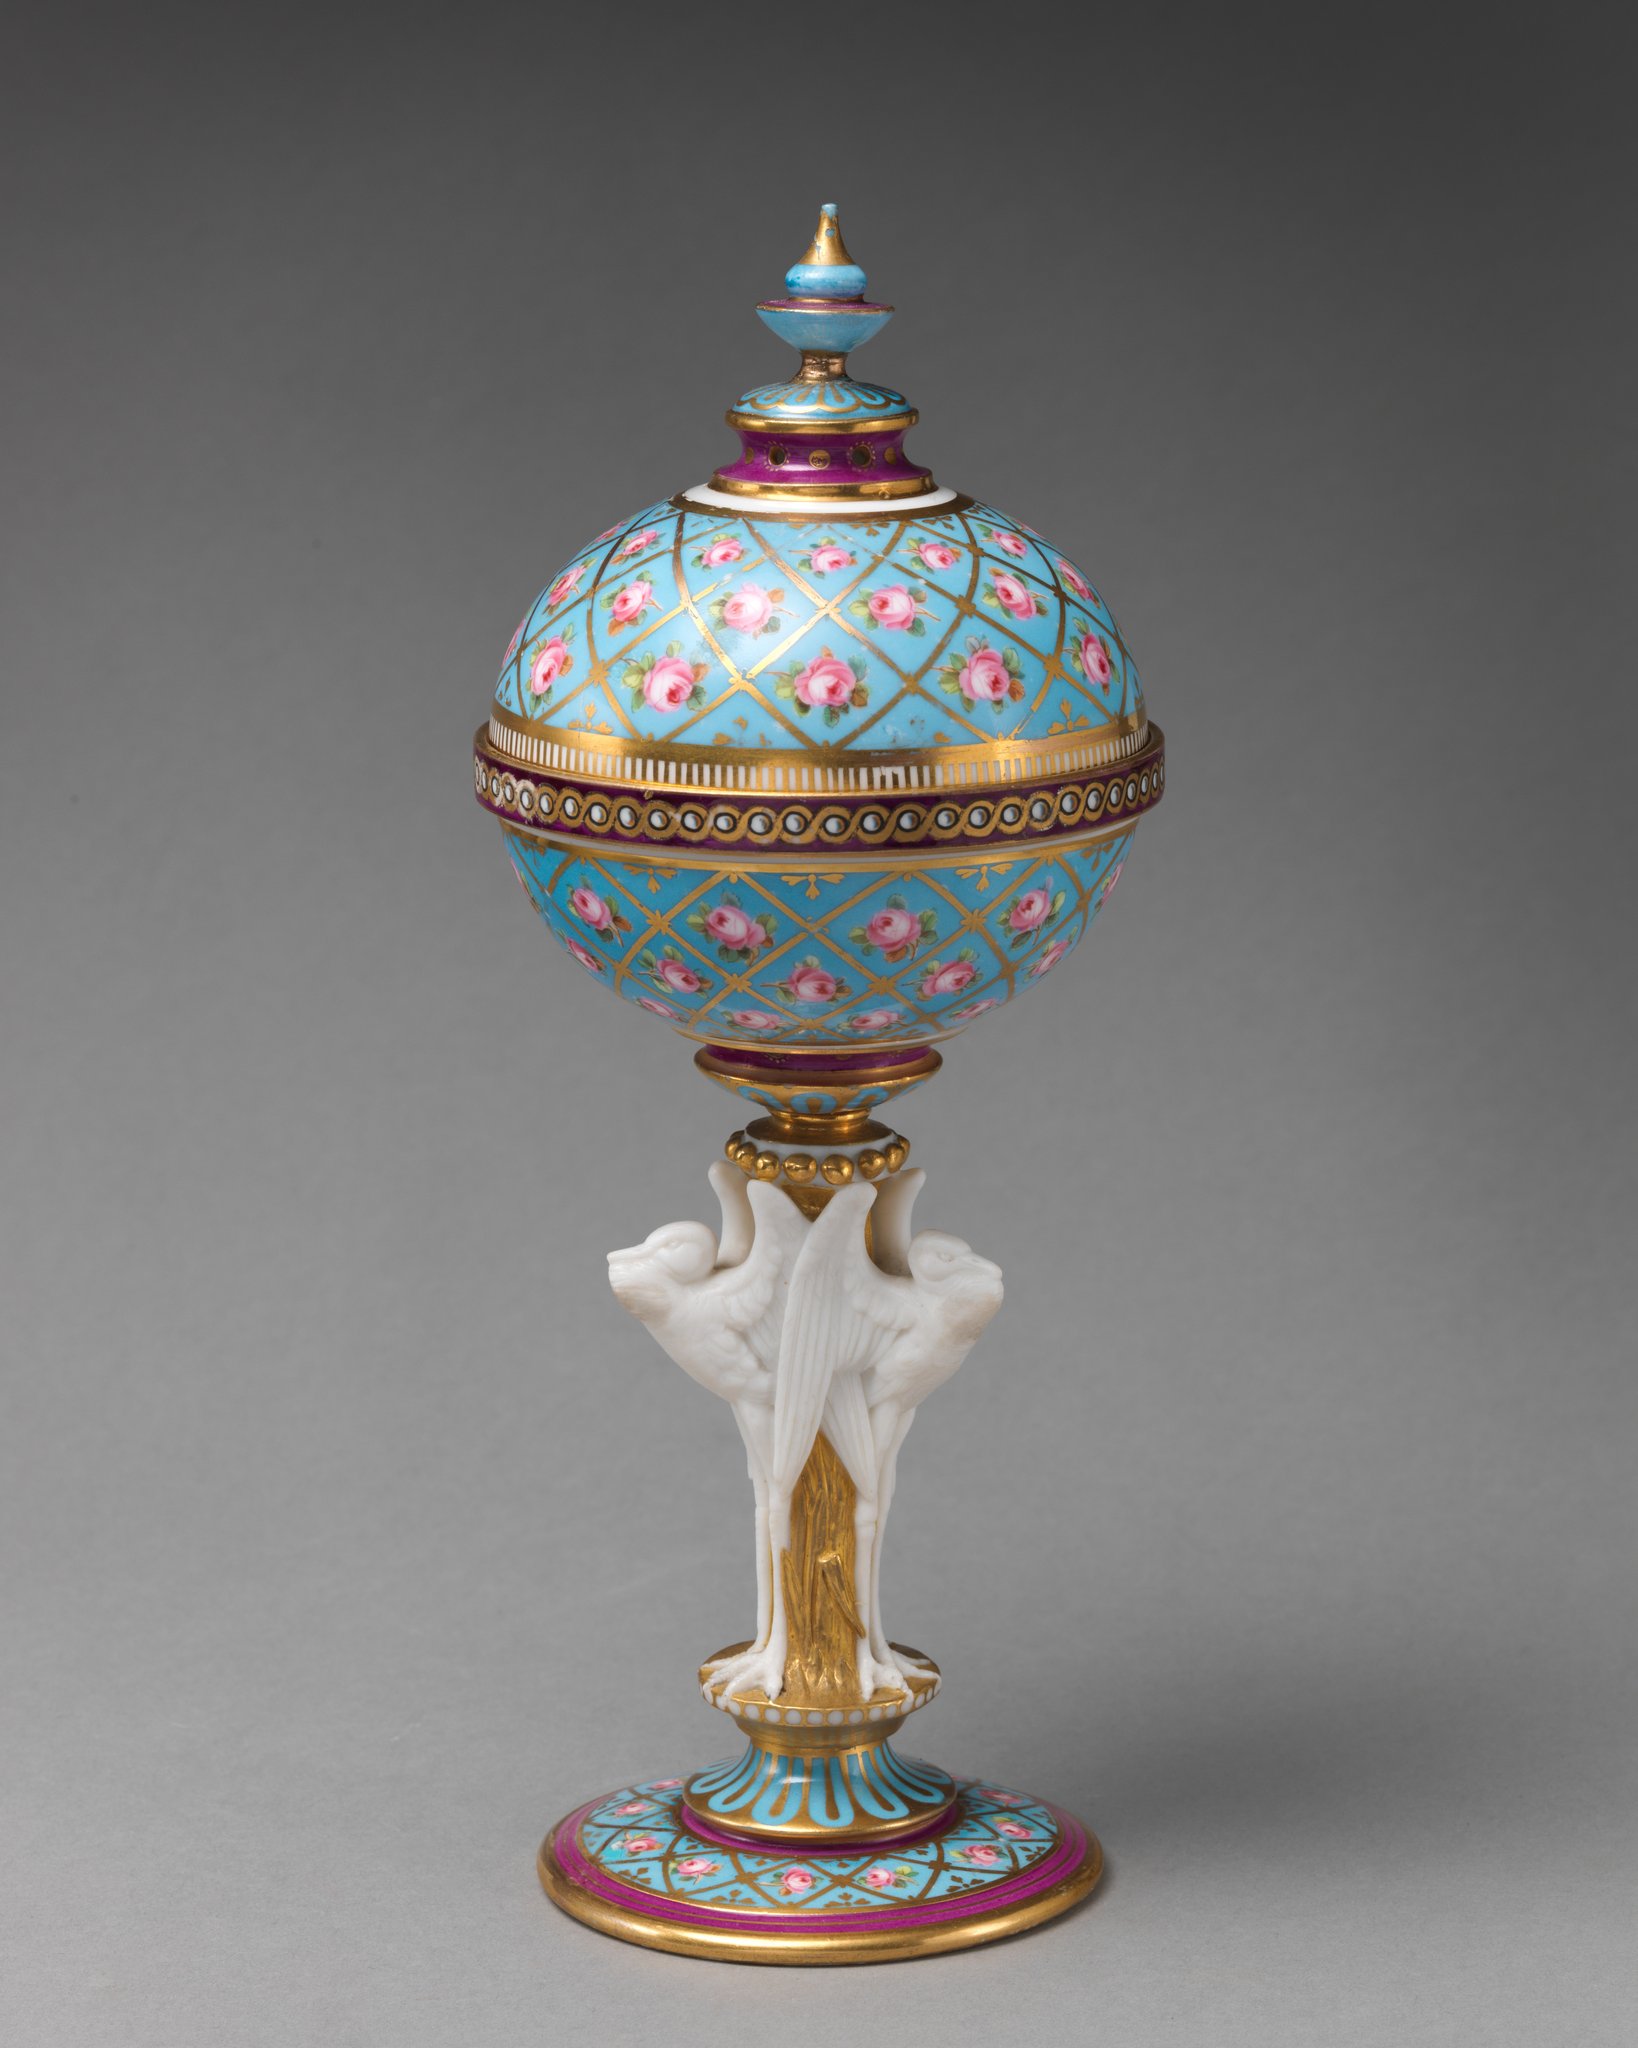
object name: container on stand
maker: minton(s)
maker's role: maker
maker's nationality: british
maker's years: 1793-2001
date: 1860-1870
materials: bone china, porcelain